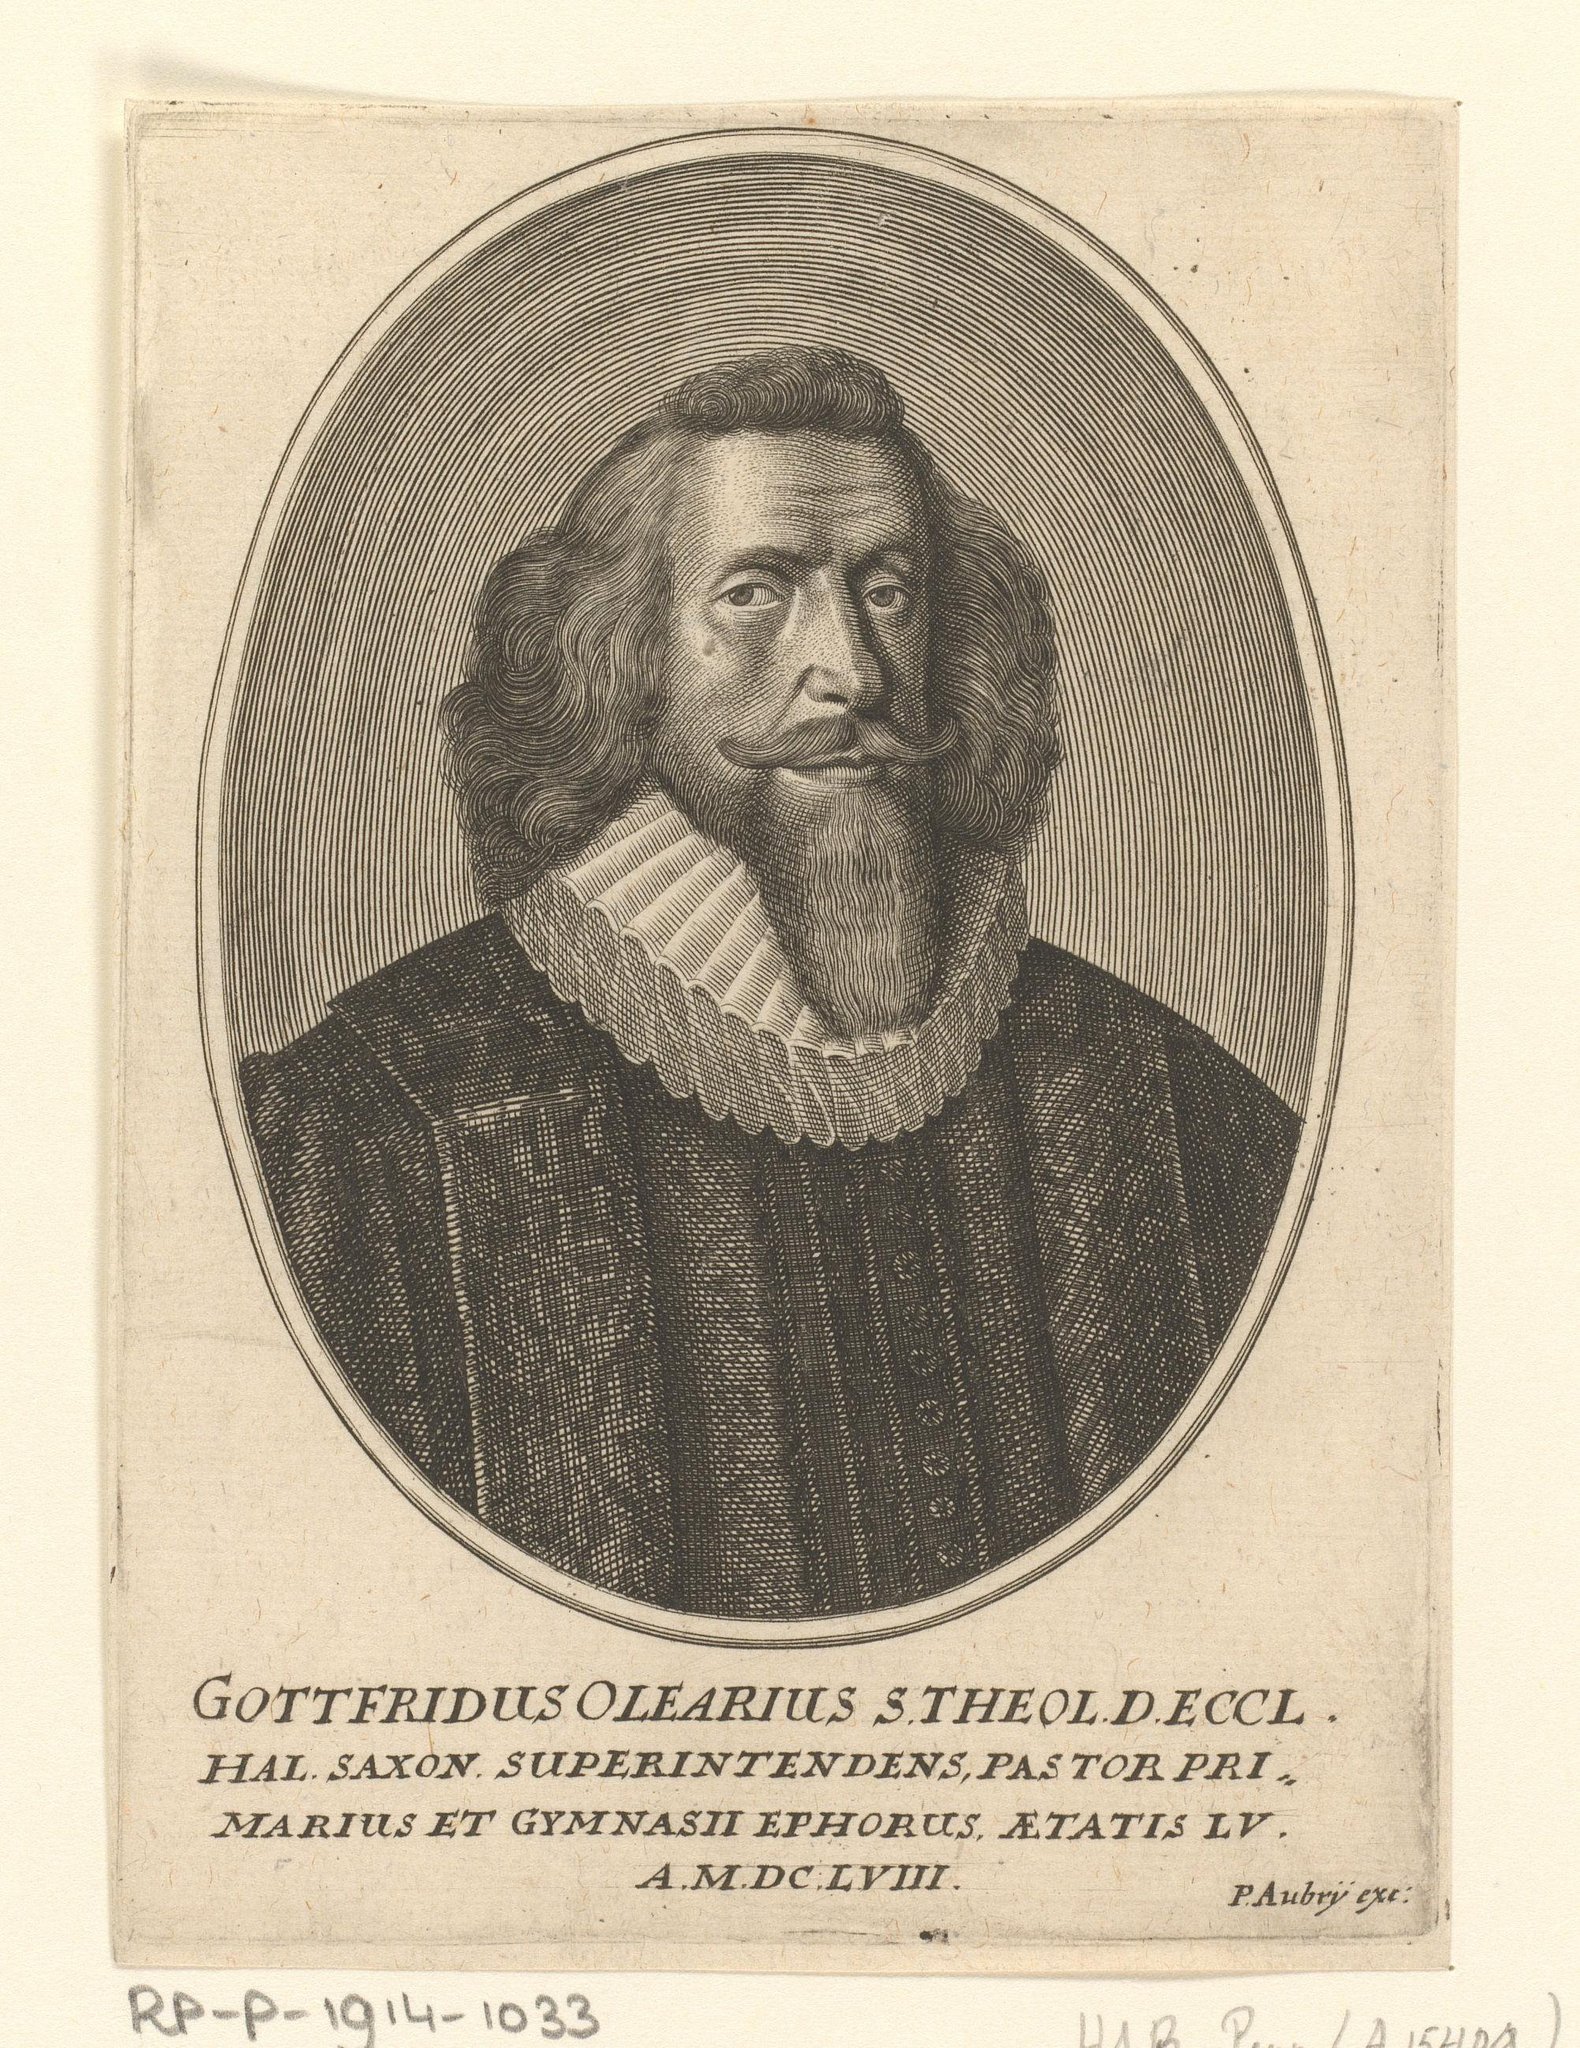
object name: print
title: Portret van Gottfried Olearius op 55-jarige leeftijd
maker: Anonymous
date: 1658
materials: paper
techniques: engraving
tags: theologian, historical persons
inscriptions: collector's mark: Lugt 2228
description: Met vierregelig onderschrift in het Latijn.